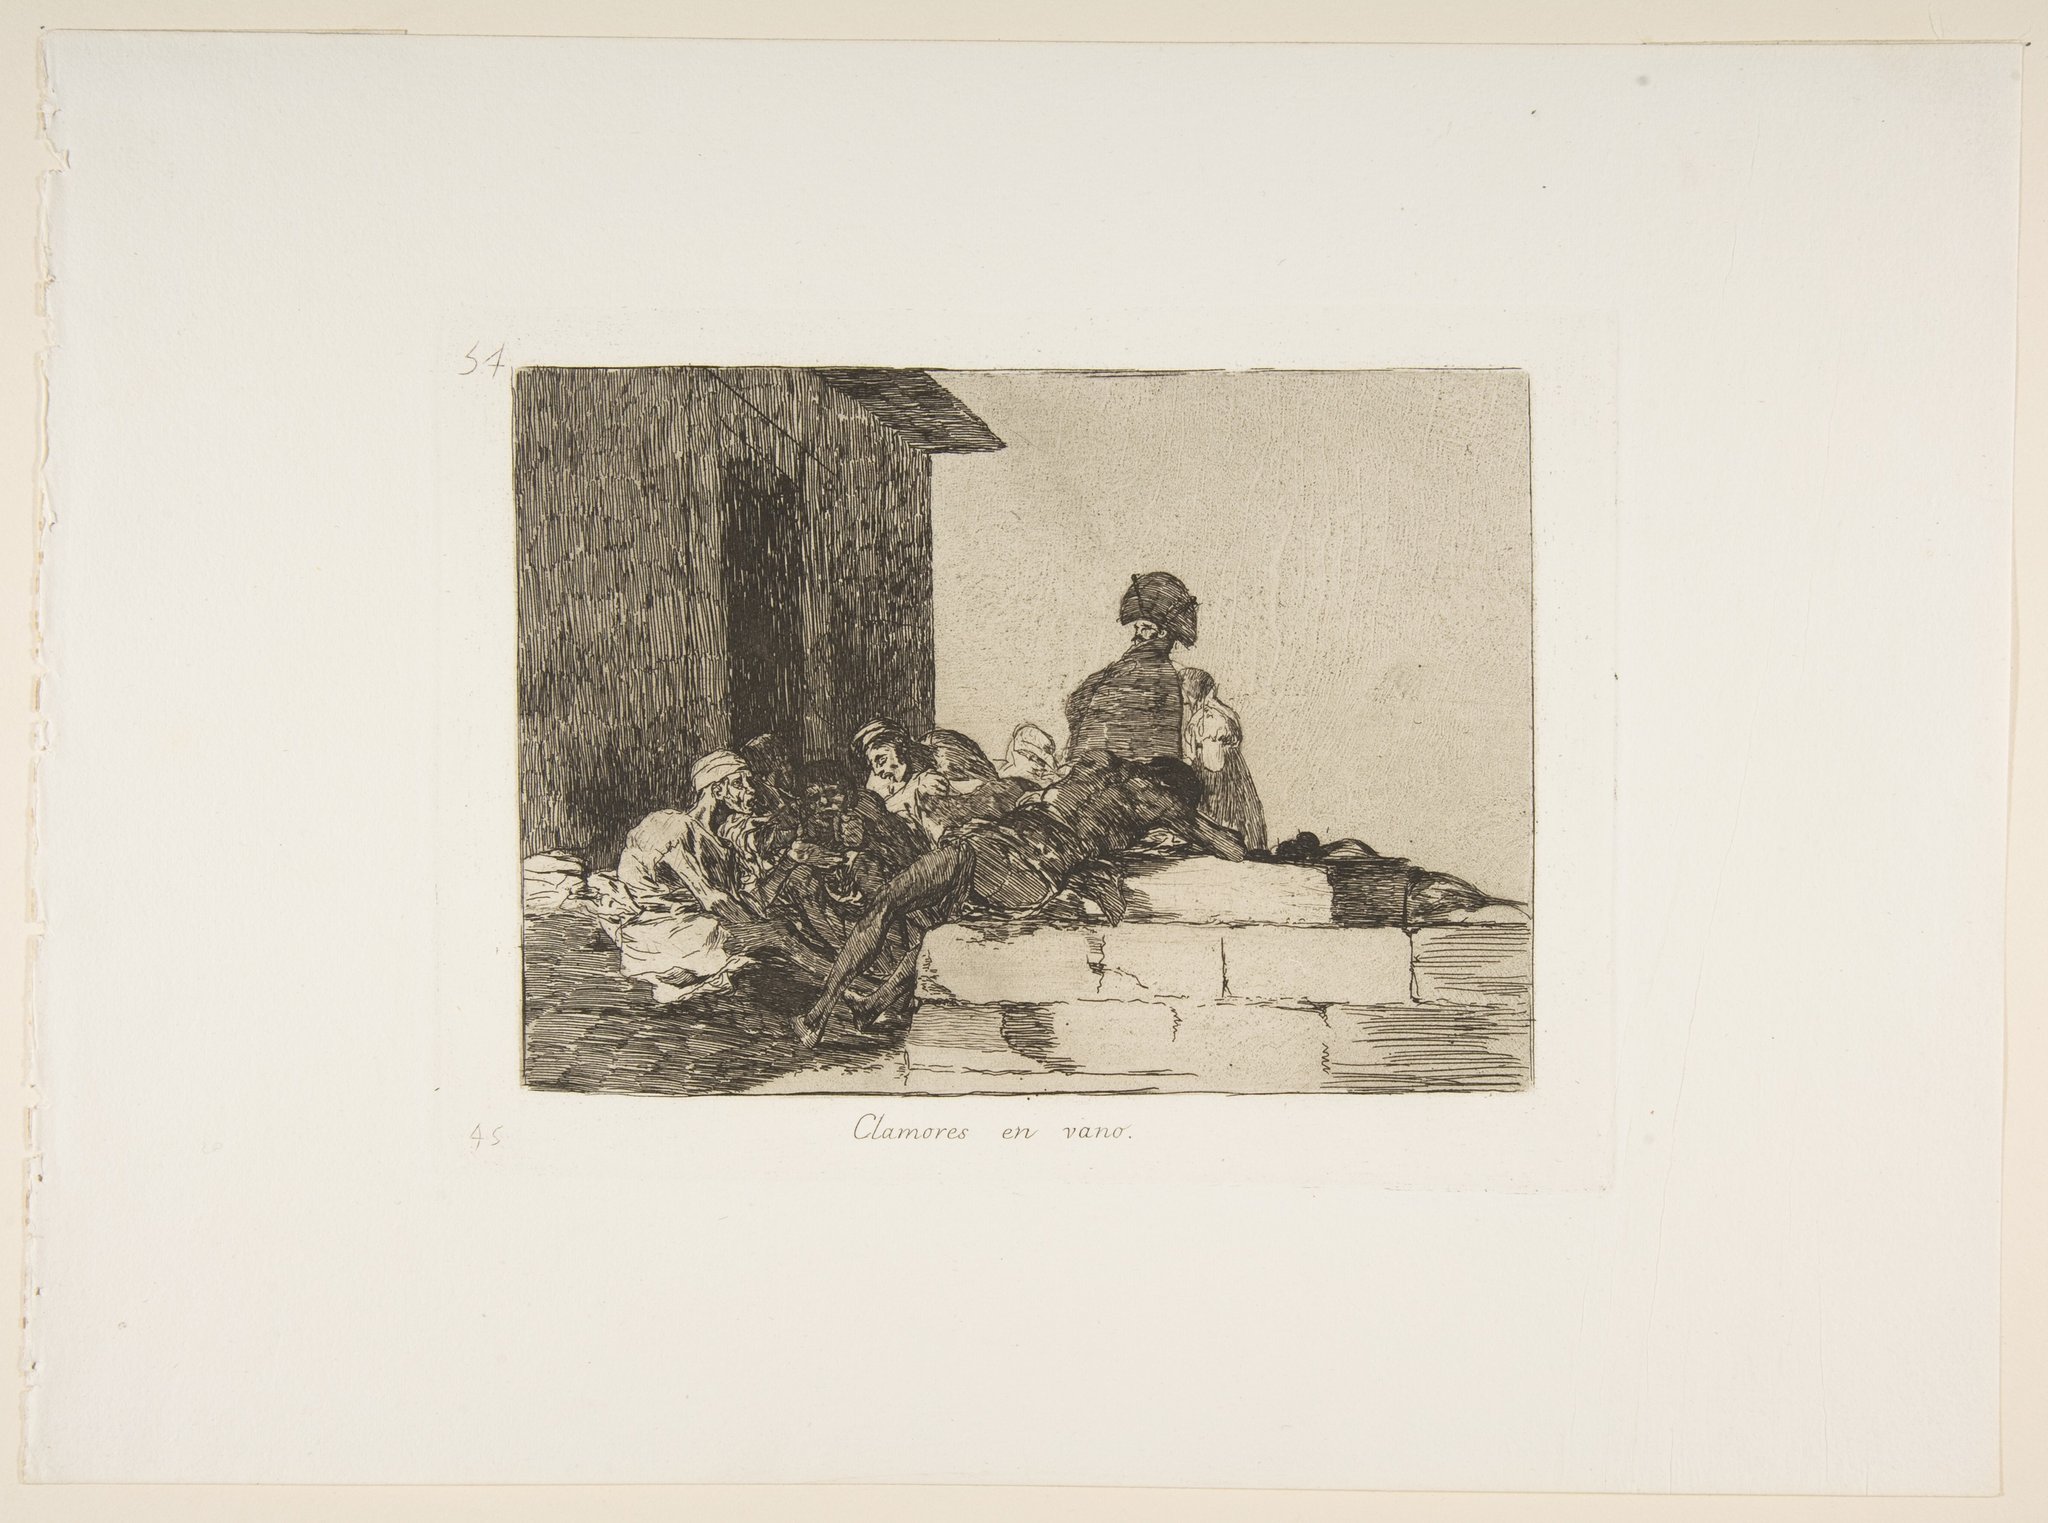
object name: print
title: Plate 54 from "The Disasters of War" (Los Desastres de la Guerra): 'Appeals are in vain' (Clamores en vano)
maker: goya (francisco de goya y lucientes)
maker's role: artist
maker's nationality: spanish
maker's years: 1746-1828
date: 1811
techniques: engraving, etching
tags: suffering,men